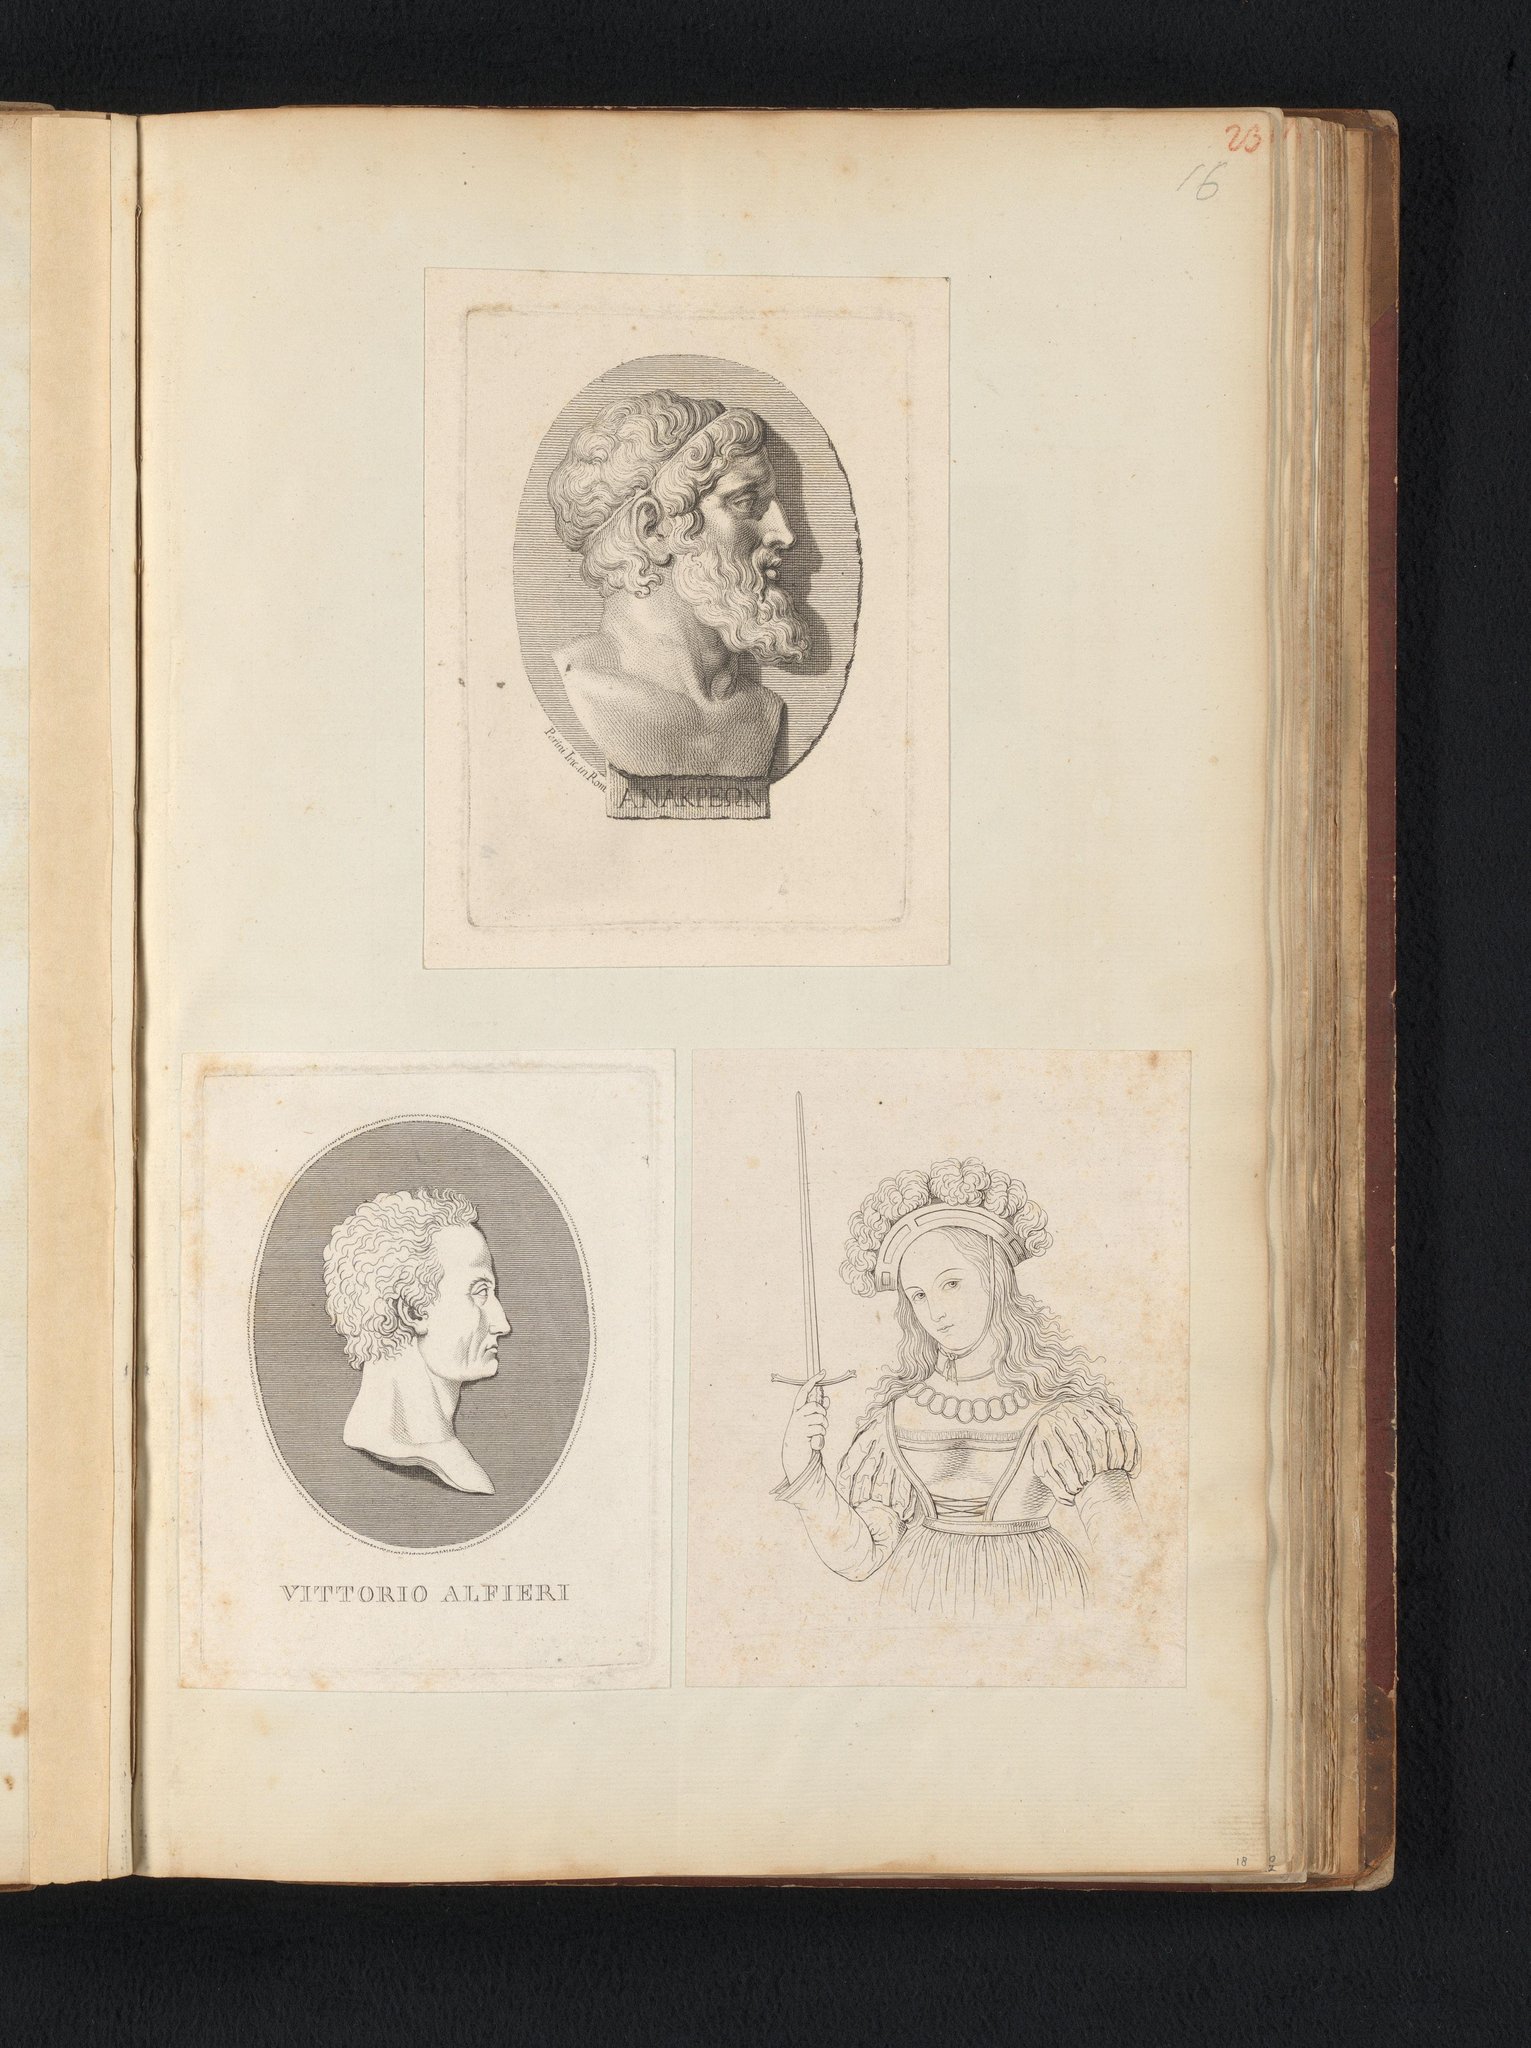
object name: print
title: Portretten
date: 1750-1816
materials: paper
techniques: engraving, etching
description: Twee profielportretten van mannen en een vrouwelijke strijder. Onderdeel van het tweede van twee albums met ingeplakte prenten en tekeningen te dienen als tekenvoorbeelden.